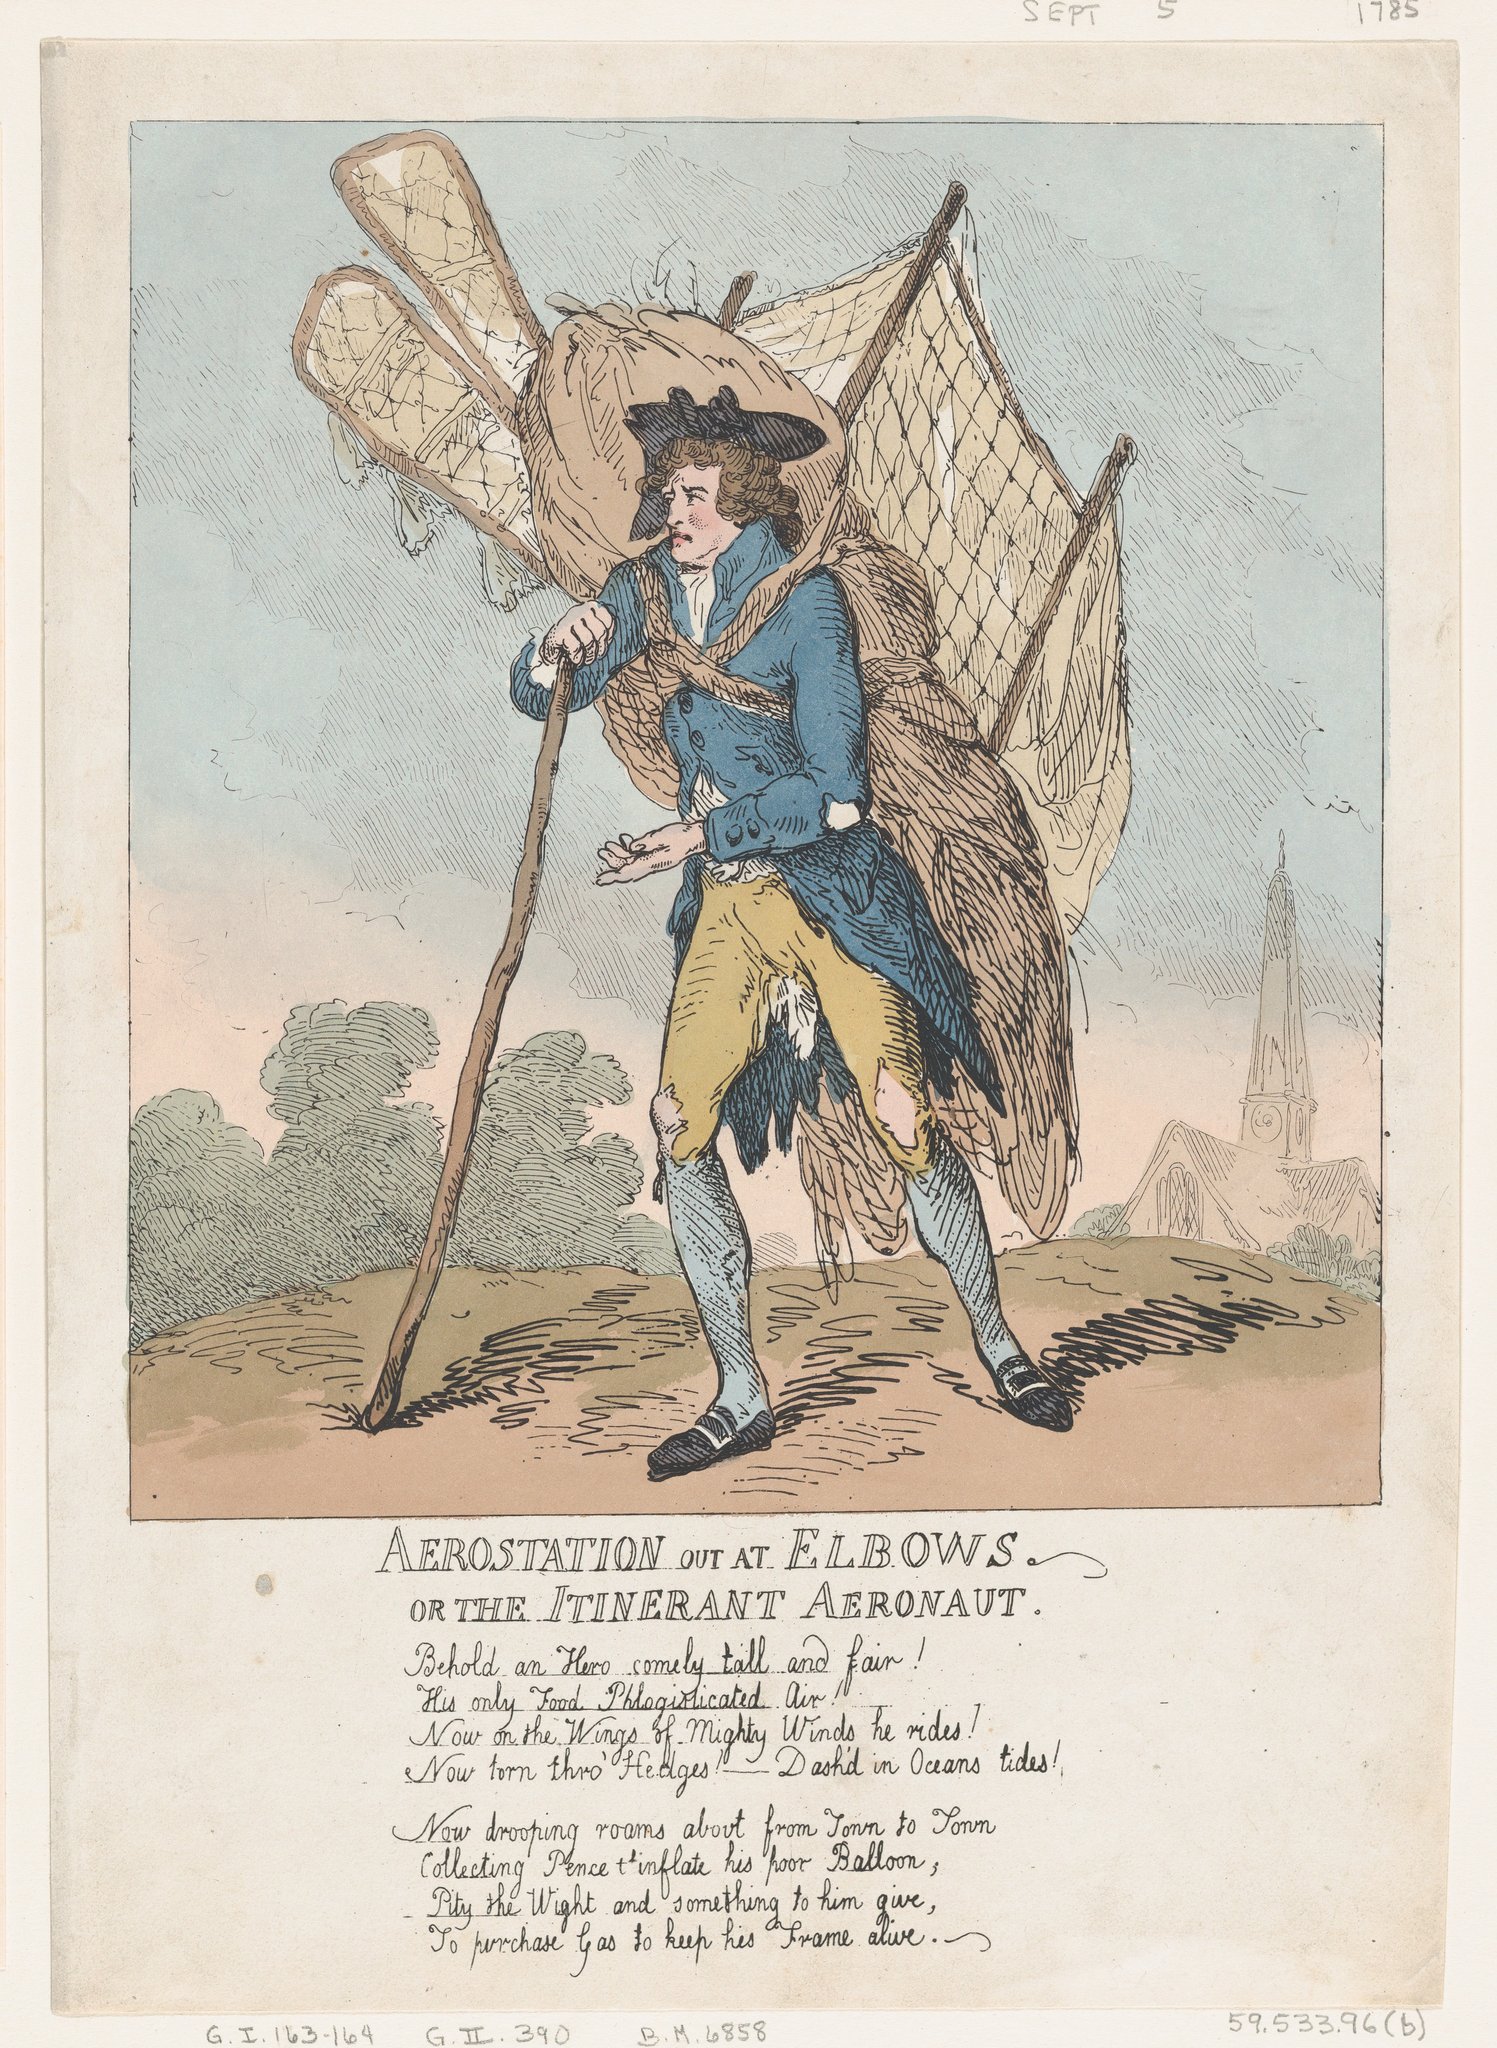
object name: print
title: Aerostation out at Elbows, or The Itinerant Aeronaut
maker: thomas rowlandson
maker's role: artist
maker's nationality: british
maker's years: 1757-1827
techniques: etching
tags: men